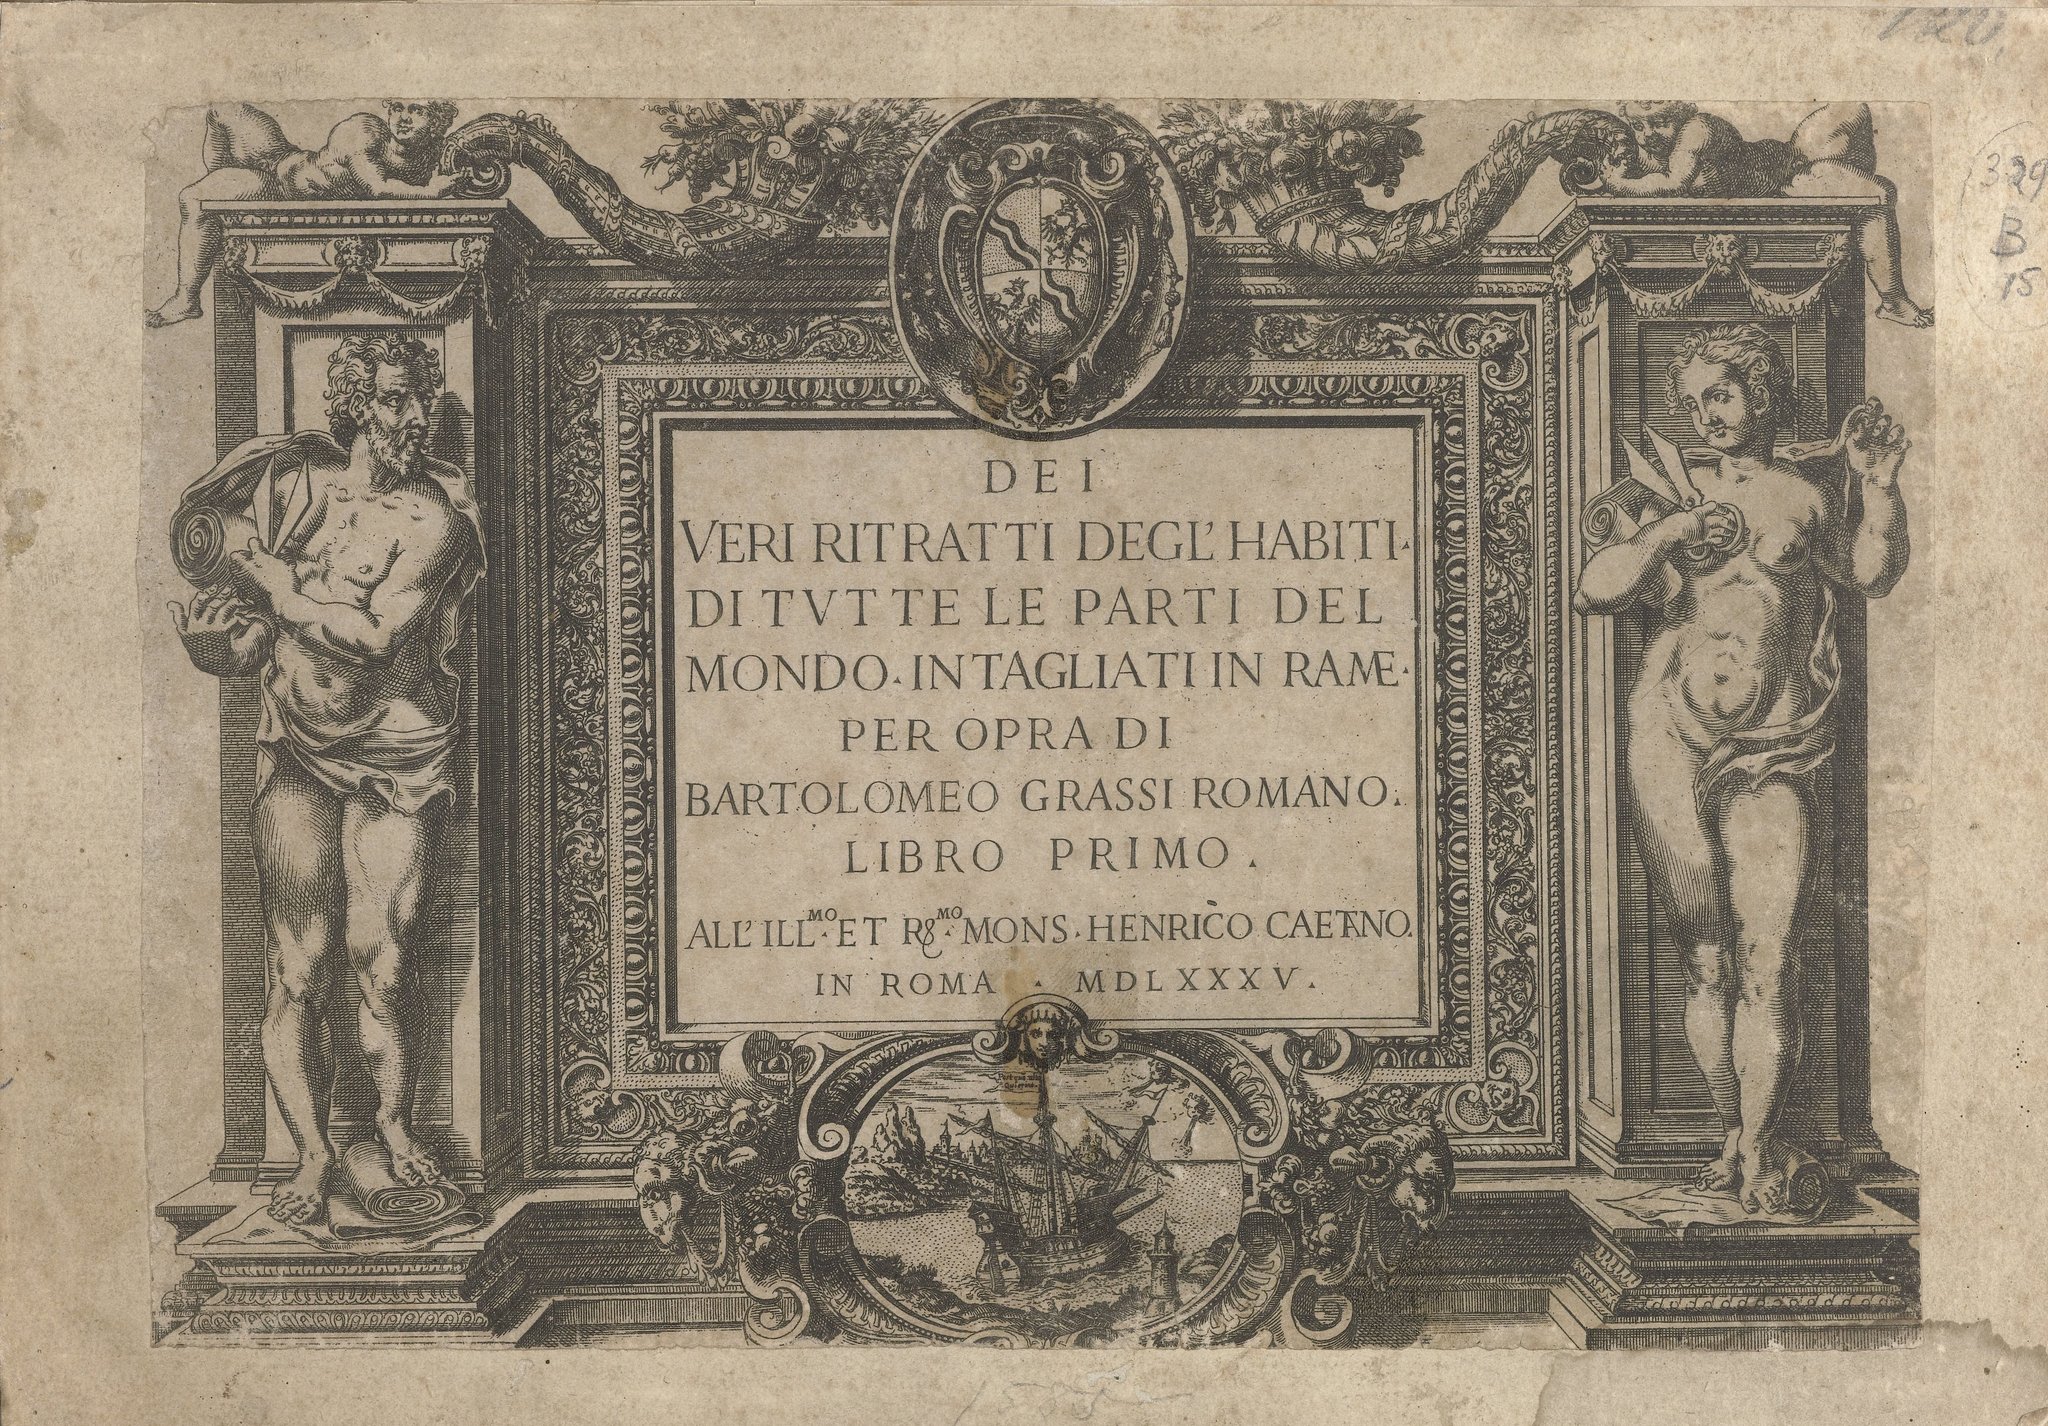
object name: titelprent, frontispice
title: Dei veri ritratti degl'habiti di tutte le parti del mondo intagliati in rame per opra di Bartolomeo Grassi. Libro Primo.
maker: bartolomeo grassi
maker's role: publisher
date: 1585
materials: paper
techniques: engraving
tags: 'cornucopia', horn of plenty, title-page, tools, aids, implements ~ crafts and industries: scissors, materials ~ textile industry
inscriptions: title: ‘Dei verei ritratti degl'habiti di tutte le parti del mondo intagliati in rame per opra di Bartolomeo Grassi. Libro Primo.’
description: Titelblad van serie kostuumprenten. Titel in het midden, in ornamentlijst met middenboven het wapen van.... Twee putti met hoornen van overvloed. Middenonder een cartouche met ramskoppen, waarin de afbeelding van een zeilschip in storm op zee. Rechts een naakte staande vrouw met schaar en rol stof; links een naakte staande man met dezelfde attributen. Prent uit album 'Dei veri ritratti degl'habiti di tvtte le parti del mondo intagliati in rame per opra di Bartolomeo Grassi', 1585.